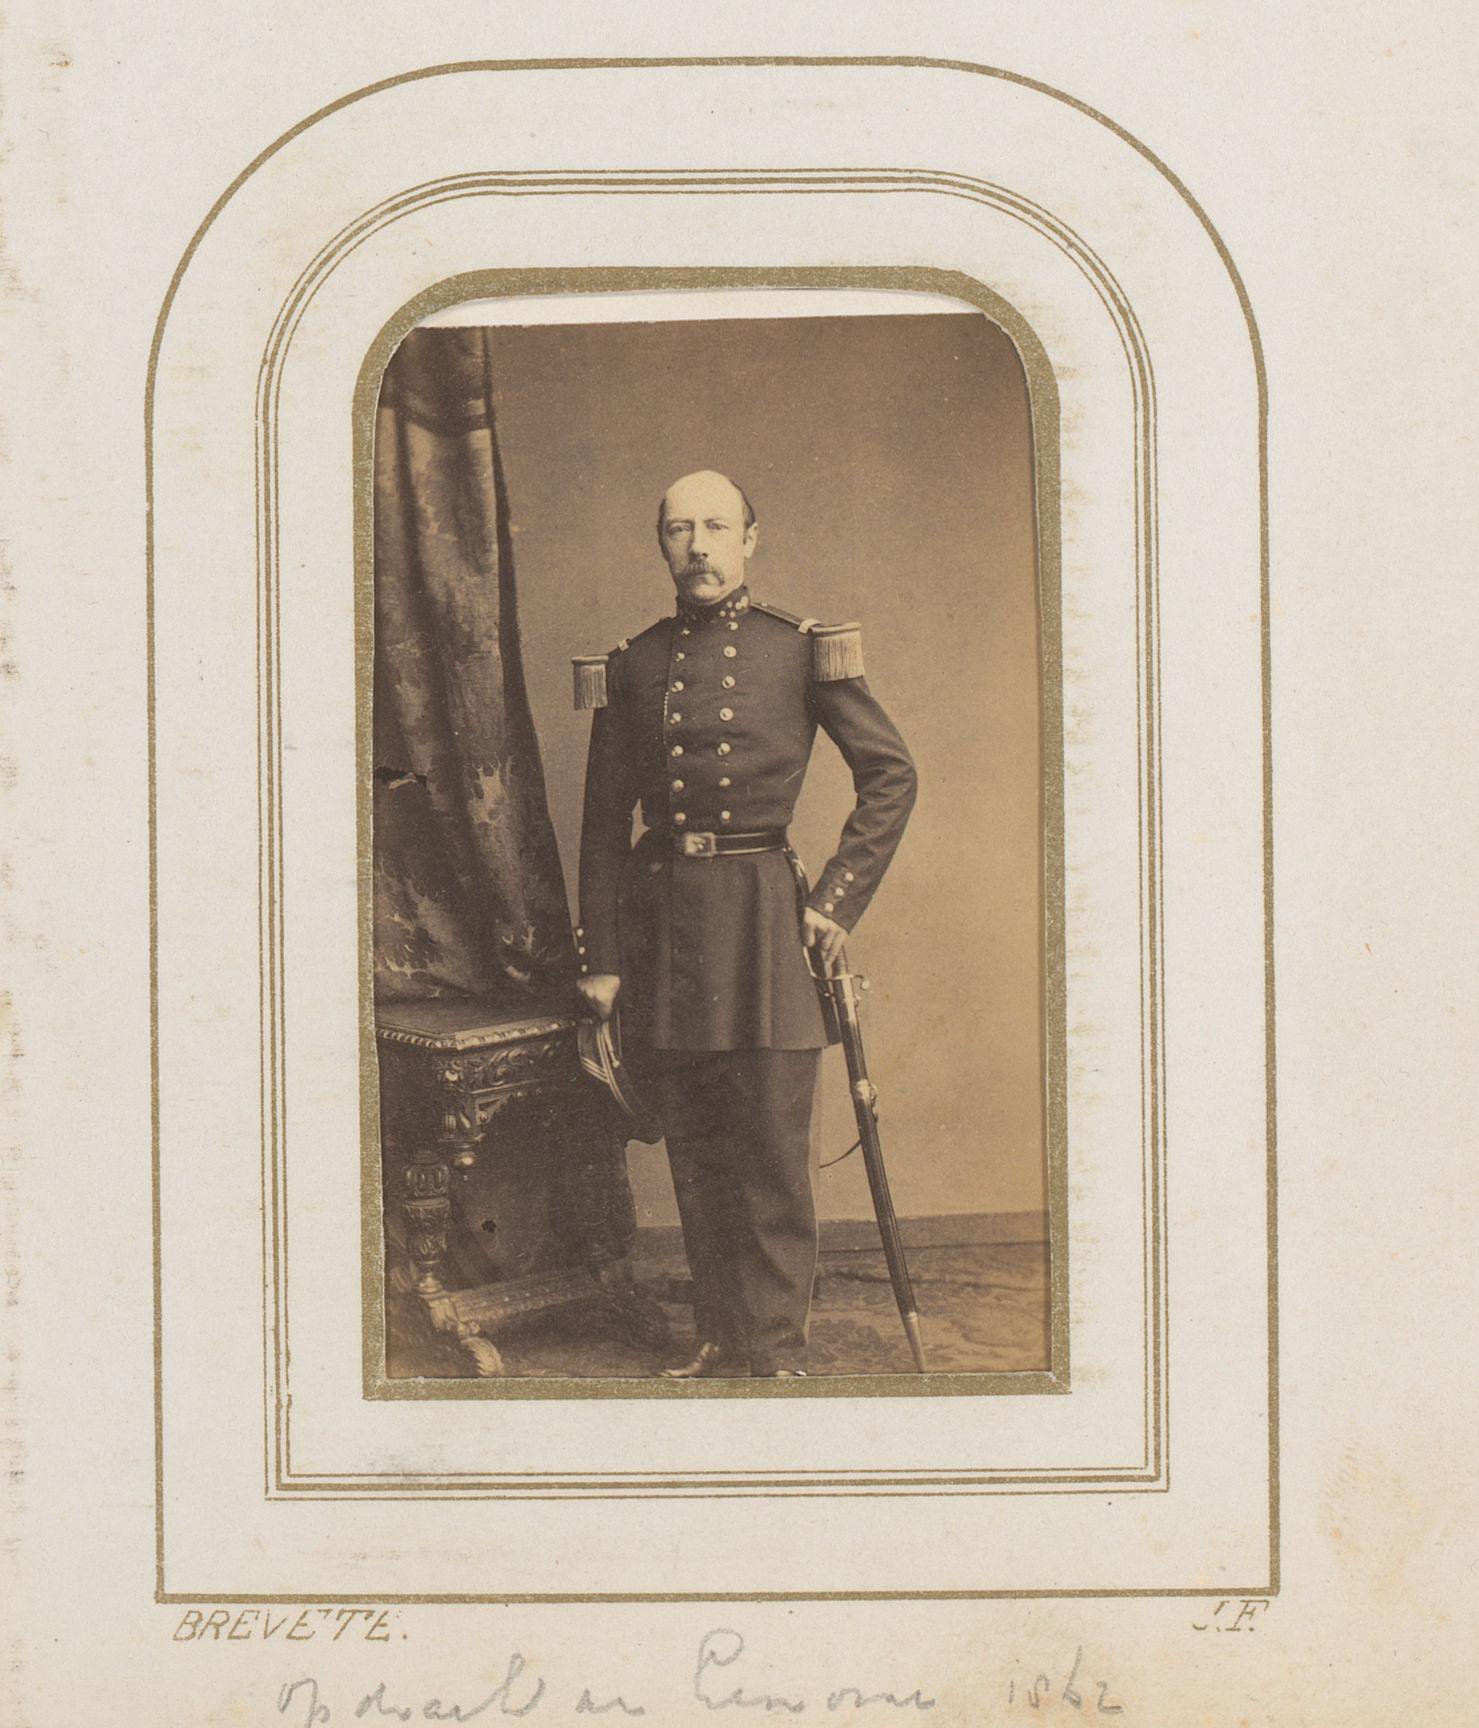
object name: photograph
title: Portret van een man in uniform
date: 1862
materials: cardboard, photographic support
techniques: albumen print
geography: brussels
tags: historical persons, (military) uniforms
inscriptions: annotation: ‘A mon bon camarade/ le Capitaine aide de camp Lemoine/ témoignage de/ sympathie/ Bruxelles Juin 1862/ [...]’, annotation: ‘opdracht aan Lemoine 1862’, inscription: ‘Atelier de Photographie/ Ghémar Frères/ Photographes du Roi/ 27, rue de l'Ecuyer/ entrée par la porte cochère/ Bruxelles’